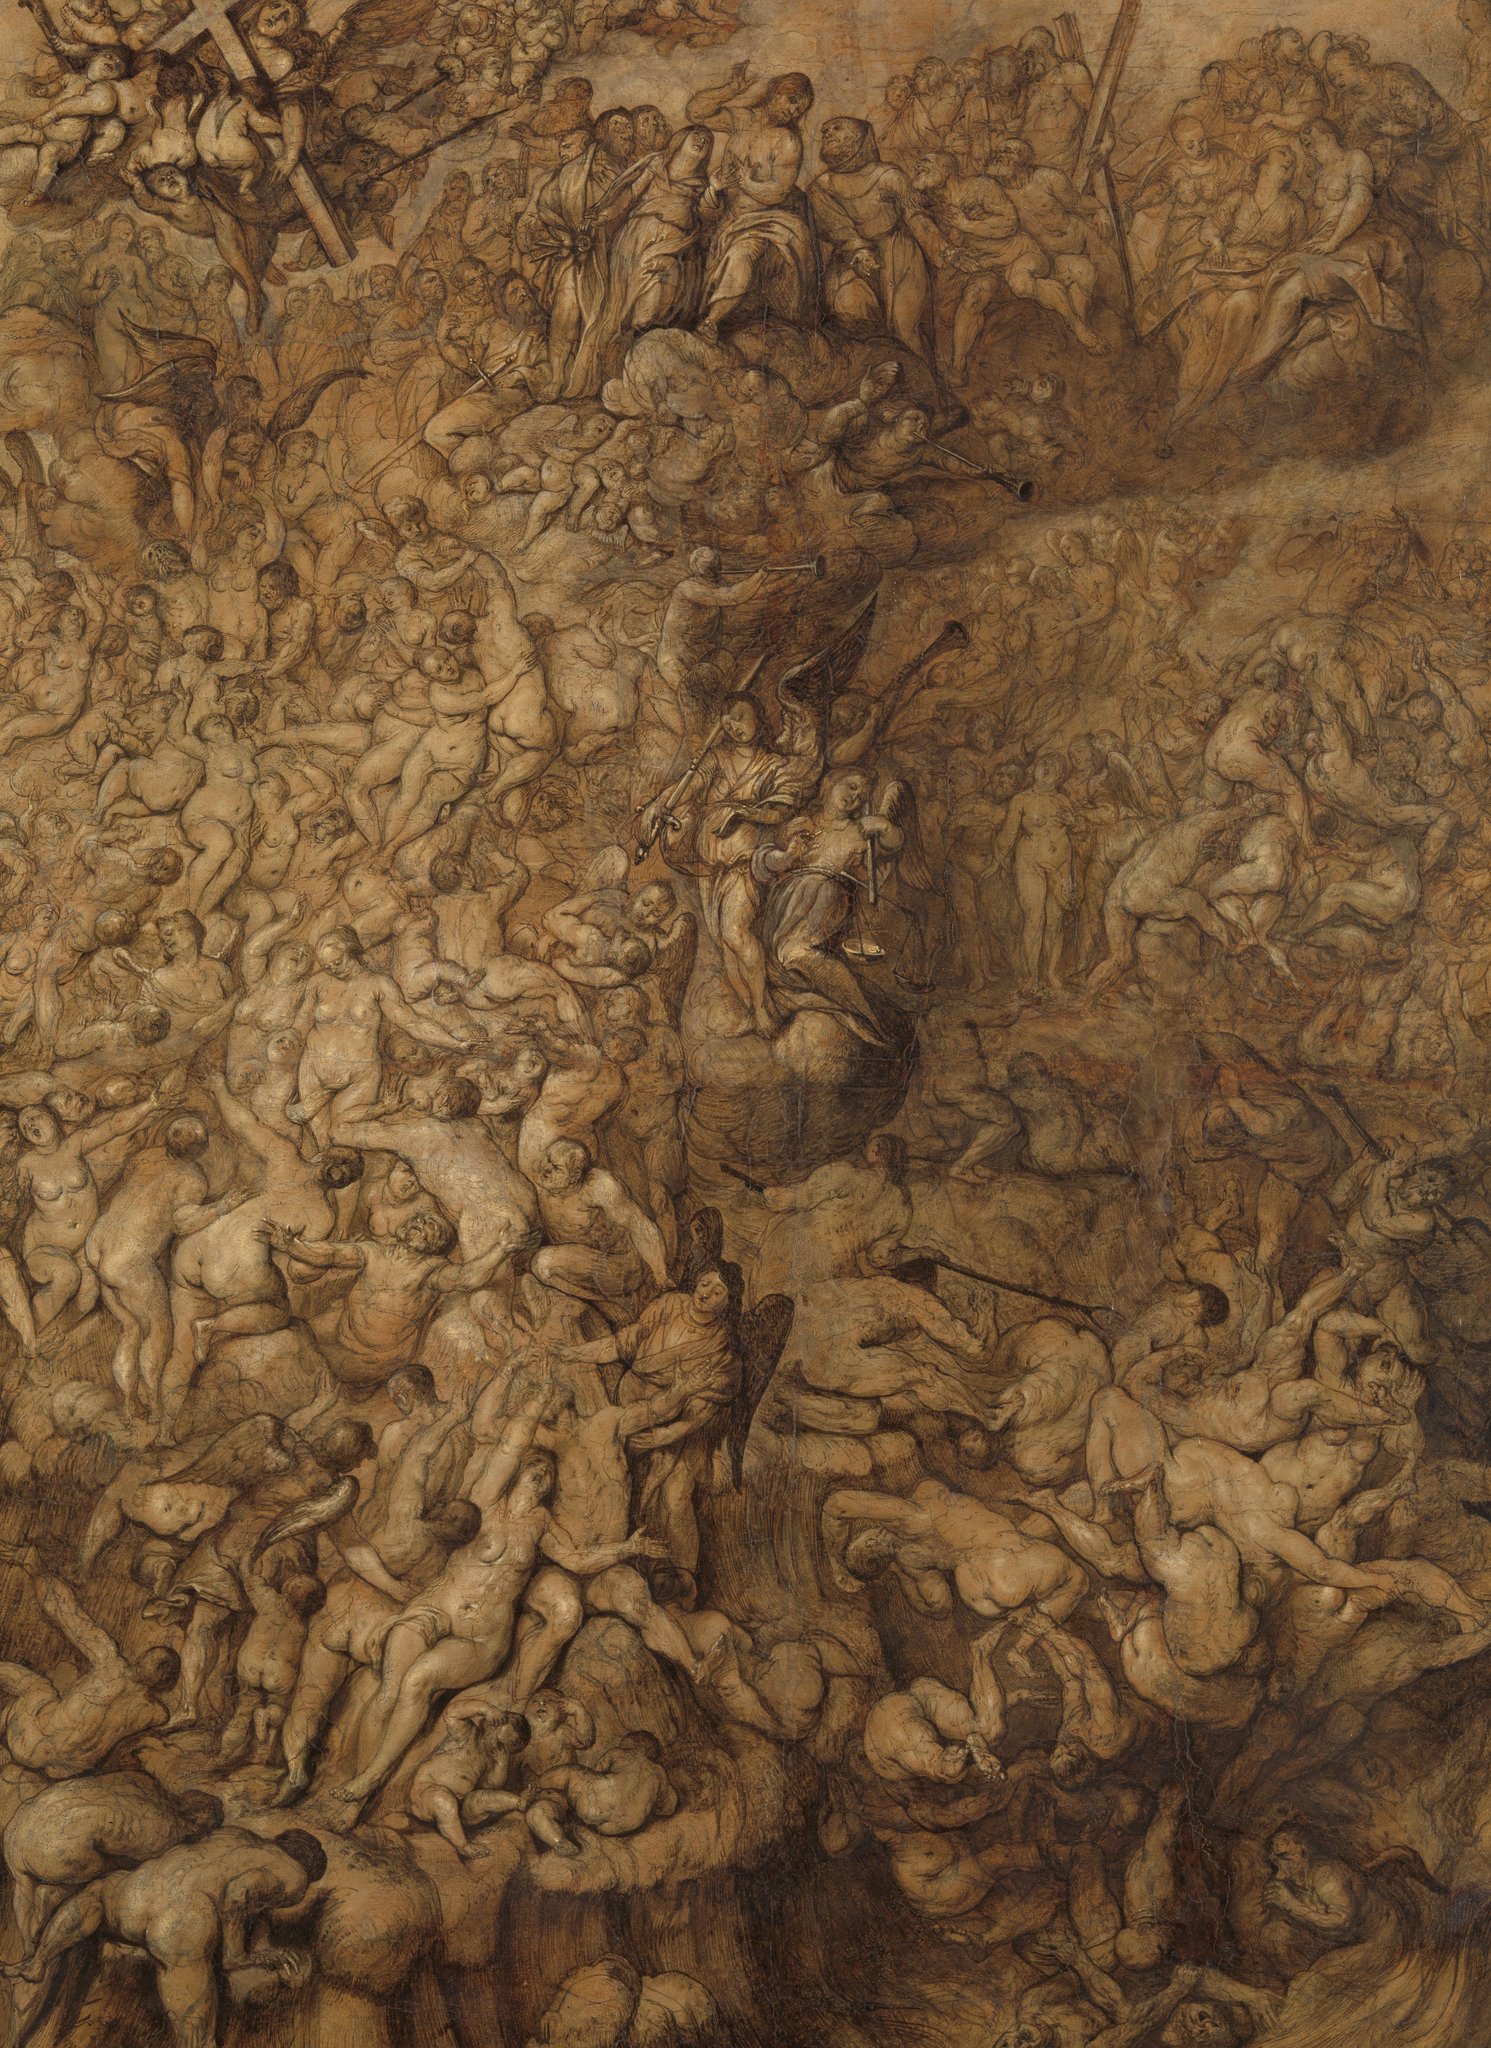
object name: painting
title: Last Judgement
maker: Anonymous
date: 1600-1649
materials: linen, oil, paper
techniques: grisaille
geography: southern netherlands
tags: comprehensive representation of last judgement: christ (with sword and lily), often surrounded by elders and sometimes accompanied by mary and john the baptist, appears in the sky with trumpeting angels (and sometimes angels holding the instruments of the passion); after the resurrection of the dead the blessed are led to heaven by angels, and the damned are dragged into hell by devils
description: Het laatste oordeel. Krioelende mensenmassa met bovenin Christus gezeten op wolken tussen Maria, heiligen en apostelen. Linksboven engelen met het kruis. In het midden twee engelen, één met een boek en een zwaard, de ander met een weegschaal. Aan de linkerzijde worden de uitverkorenen met hulp van engelen naar boven geleid, rechts tuimelen de verdoemden tussen duivels naar beneden in de vlammen van de hel.